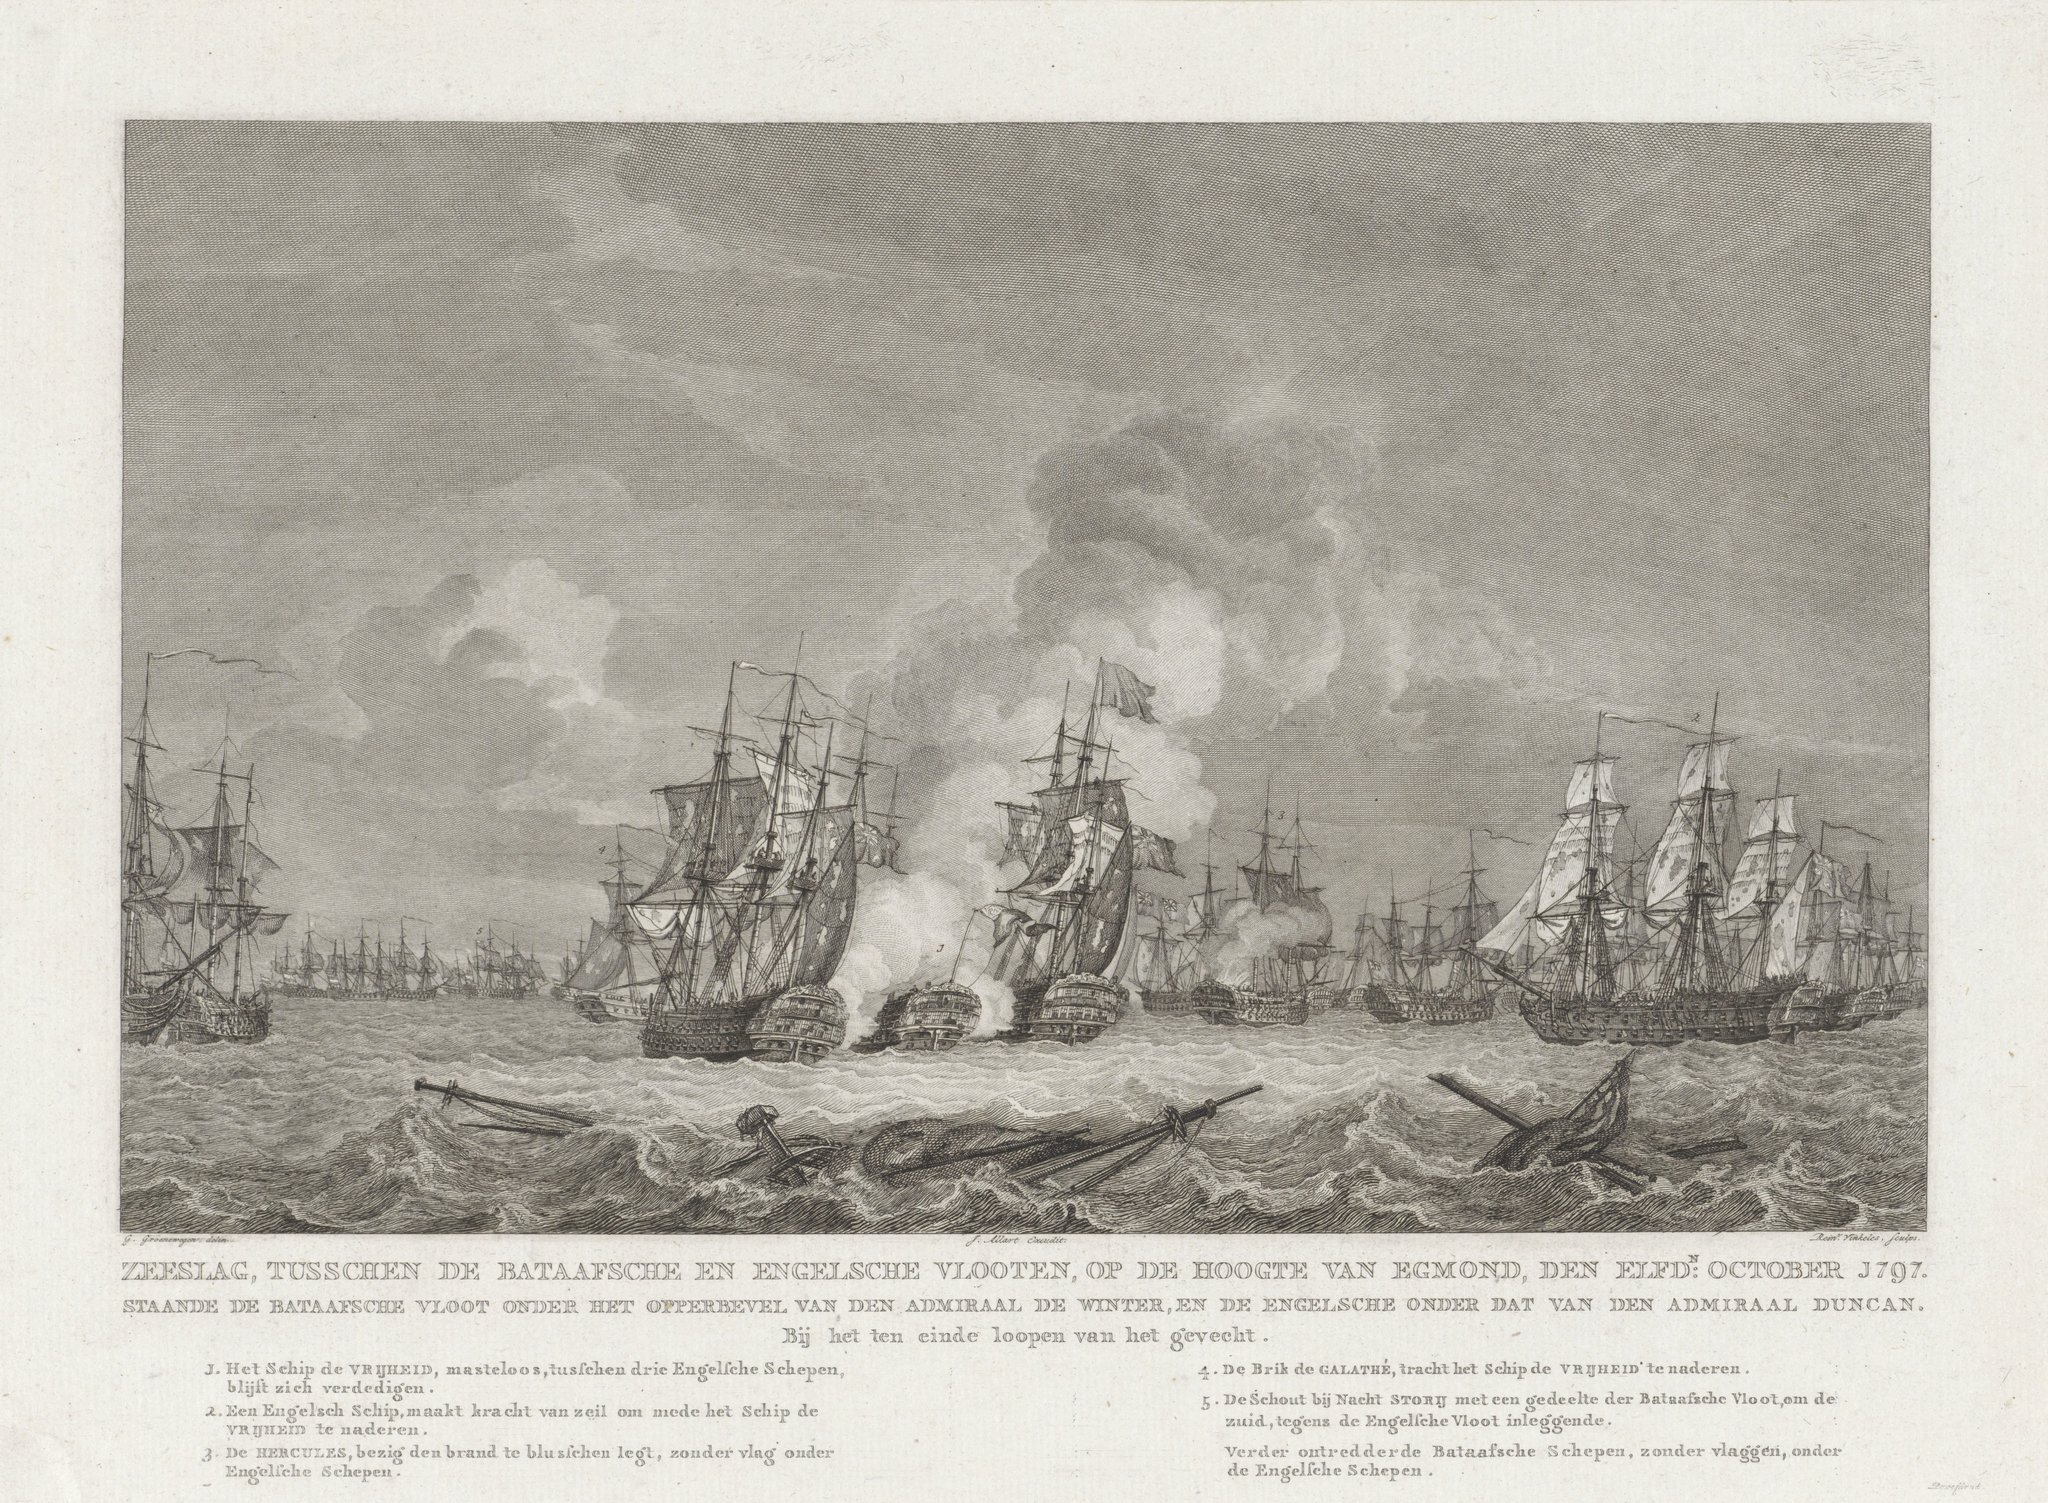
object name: print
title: Zeeslag bij Kamperduin (einde), 1797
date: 1798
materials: paper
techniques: engraving, etching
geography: amsterdam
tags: battle (+ naval force), battle of camperdown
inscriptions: collector's mark: Lugt 240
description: De Zeeslag bij Kamperduin op 11 oktober 1797 tussen de Bataafse vloot onder bevel van viceadmiraal Jan Willem de Winter en een Britse vloot onder admiraal Adam Duncan. Einde van de slag. Centraal de Vrijheid (dit schip onder bevel van De Winter) mastloos tussen drie Engelse schepen en de Hercules waarop men nog bezig is de brand te blussen; verder ontredderde Bataafse schepen onder de Engelse schepen. Vóór de legenda 1-5.